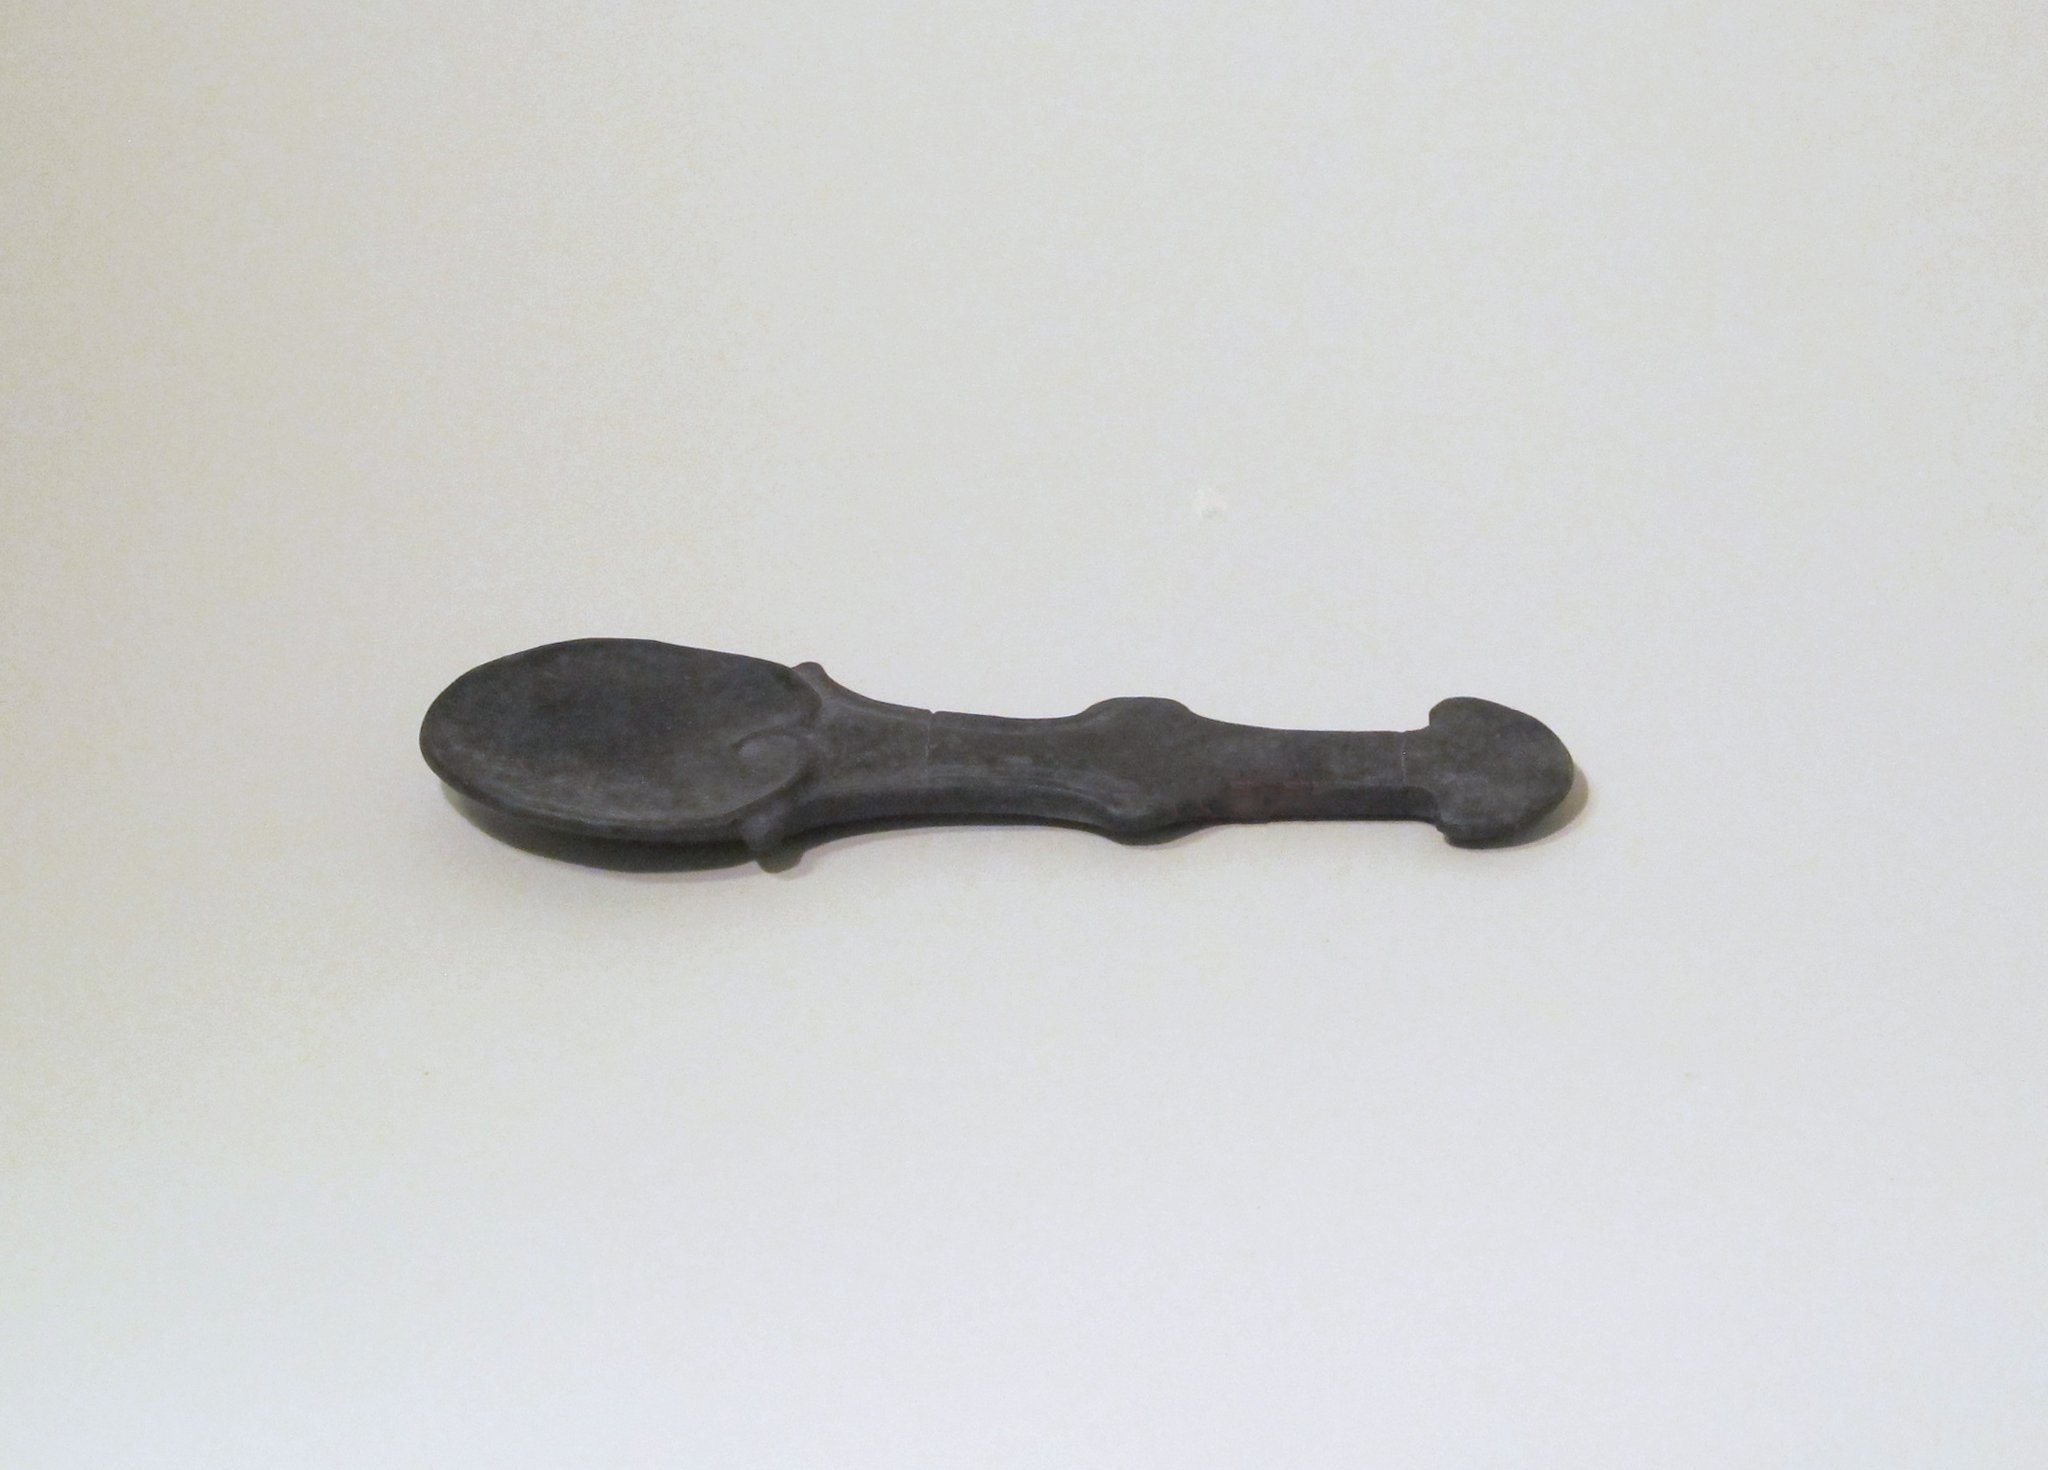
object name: focolare spoon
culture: etruscan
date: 550-501 BCE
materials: terracotta